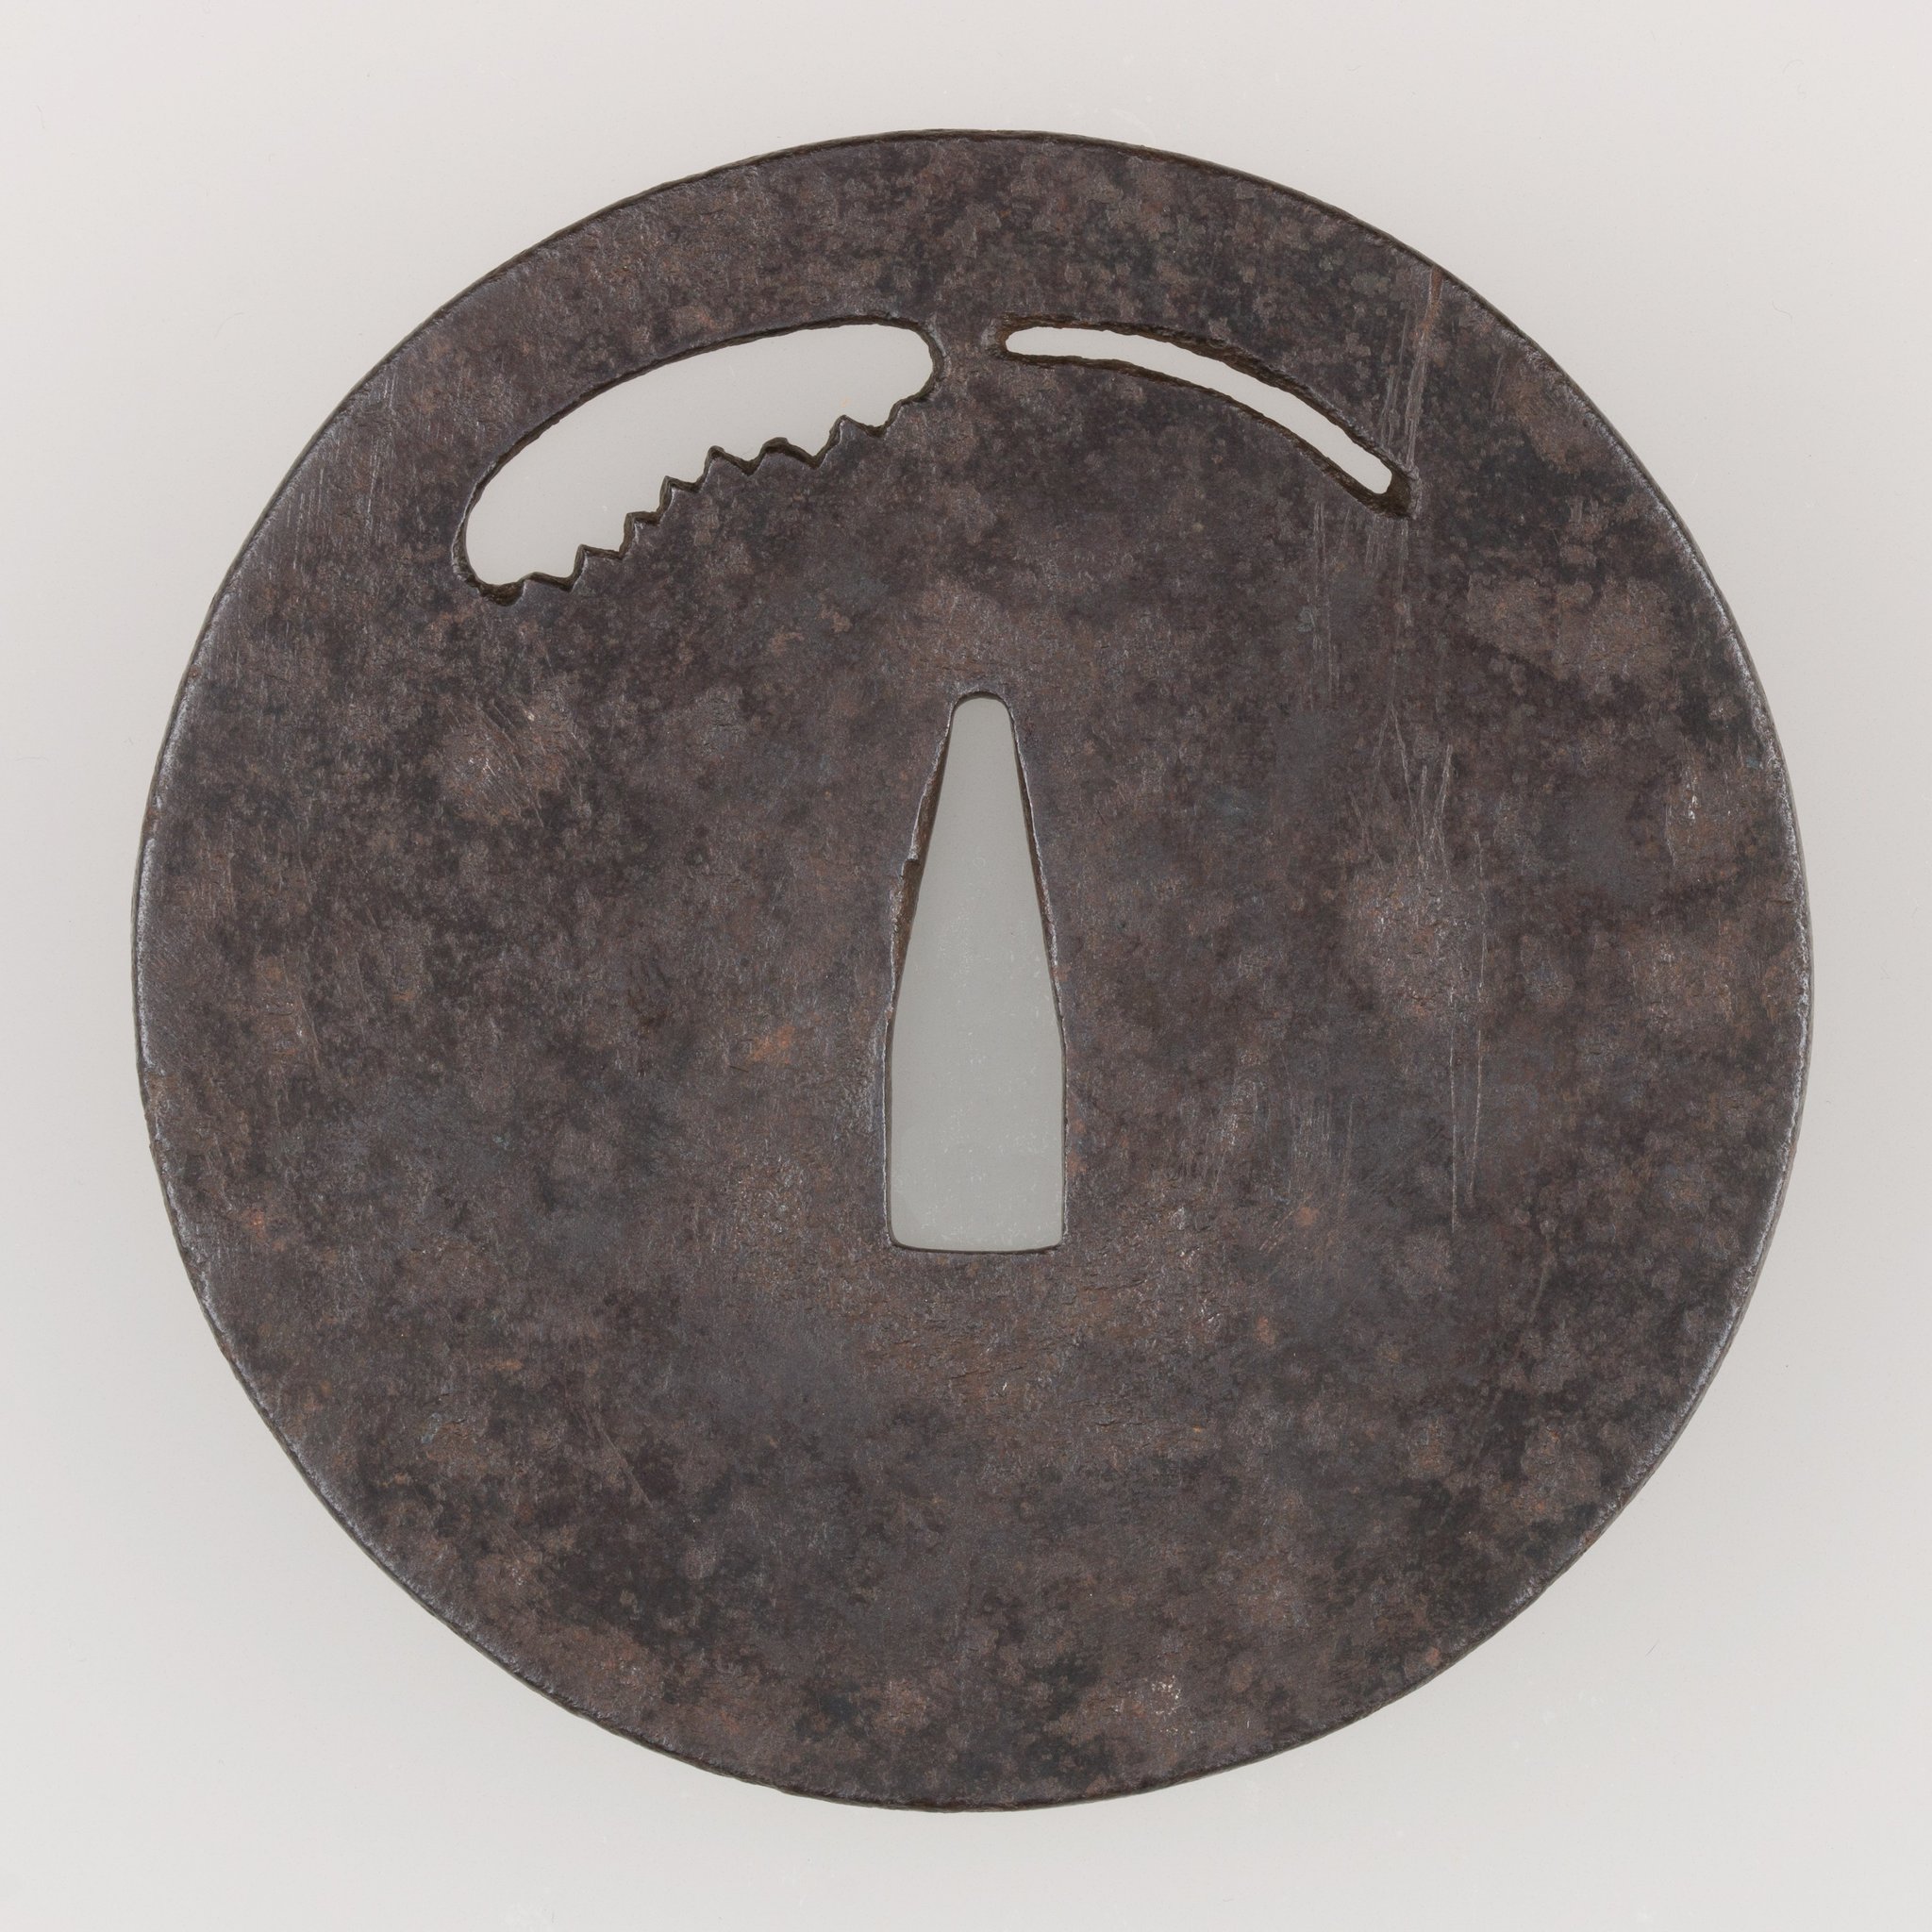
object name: sword guard tsuba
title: Sword Guard (Tsuba)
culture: japanese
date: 1367-1400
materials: copper, iron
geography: japan